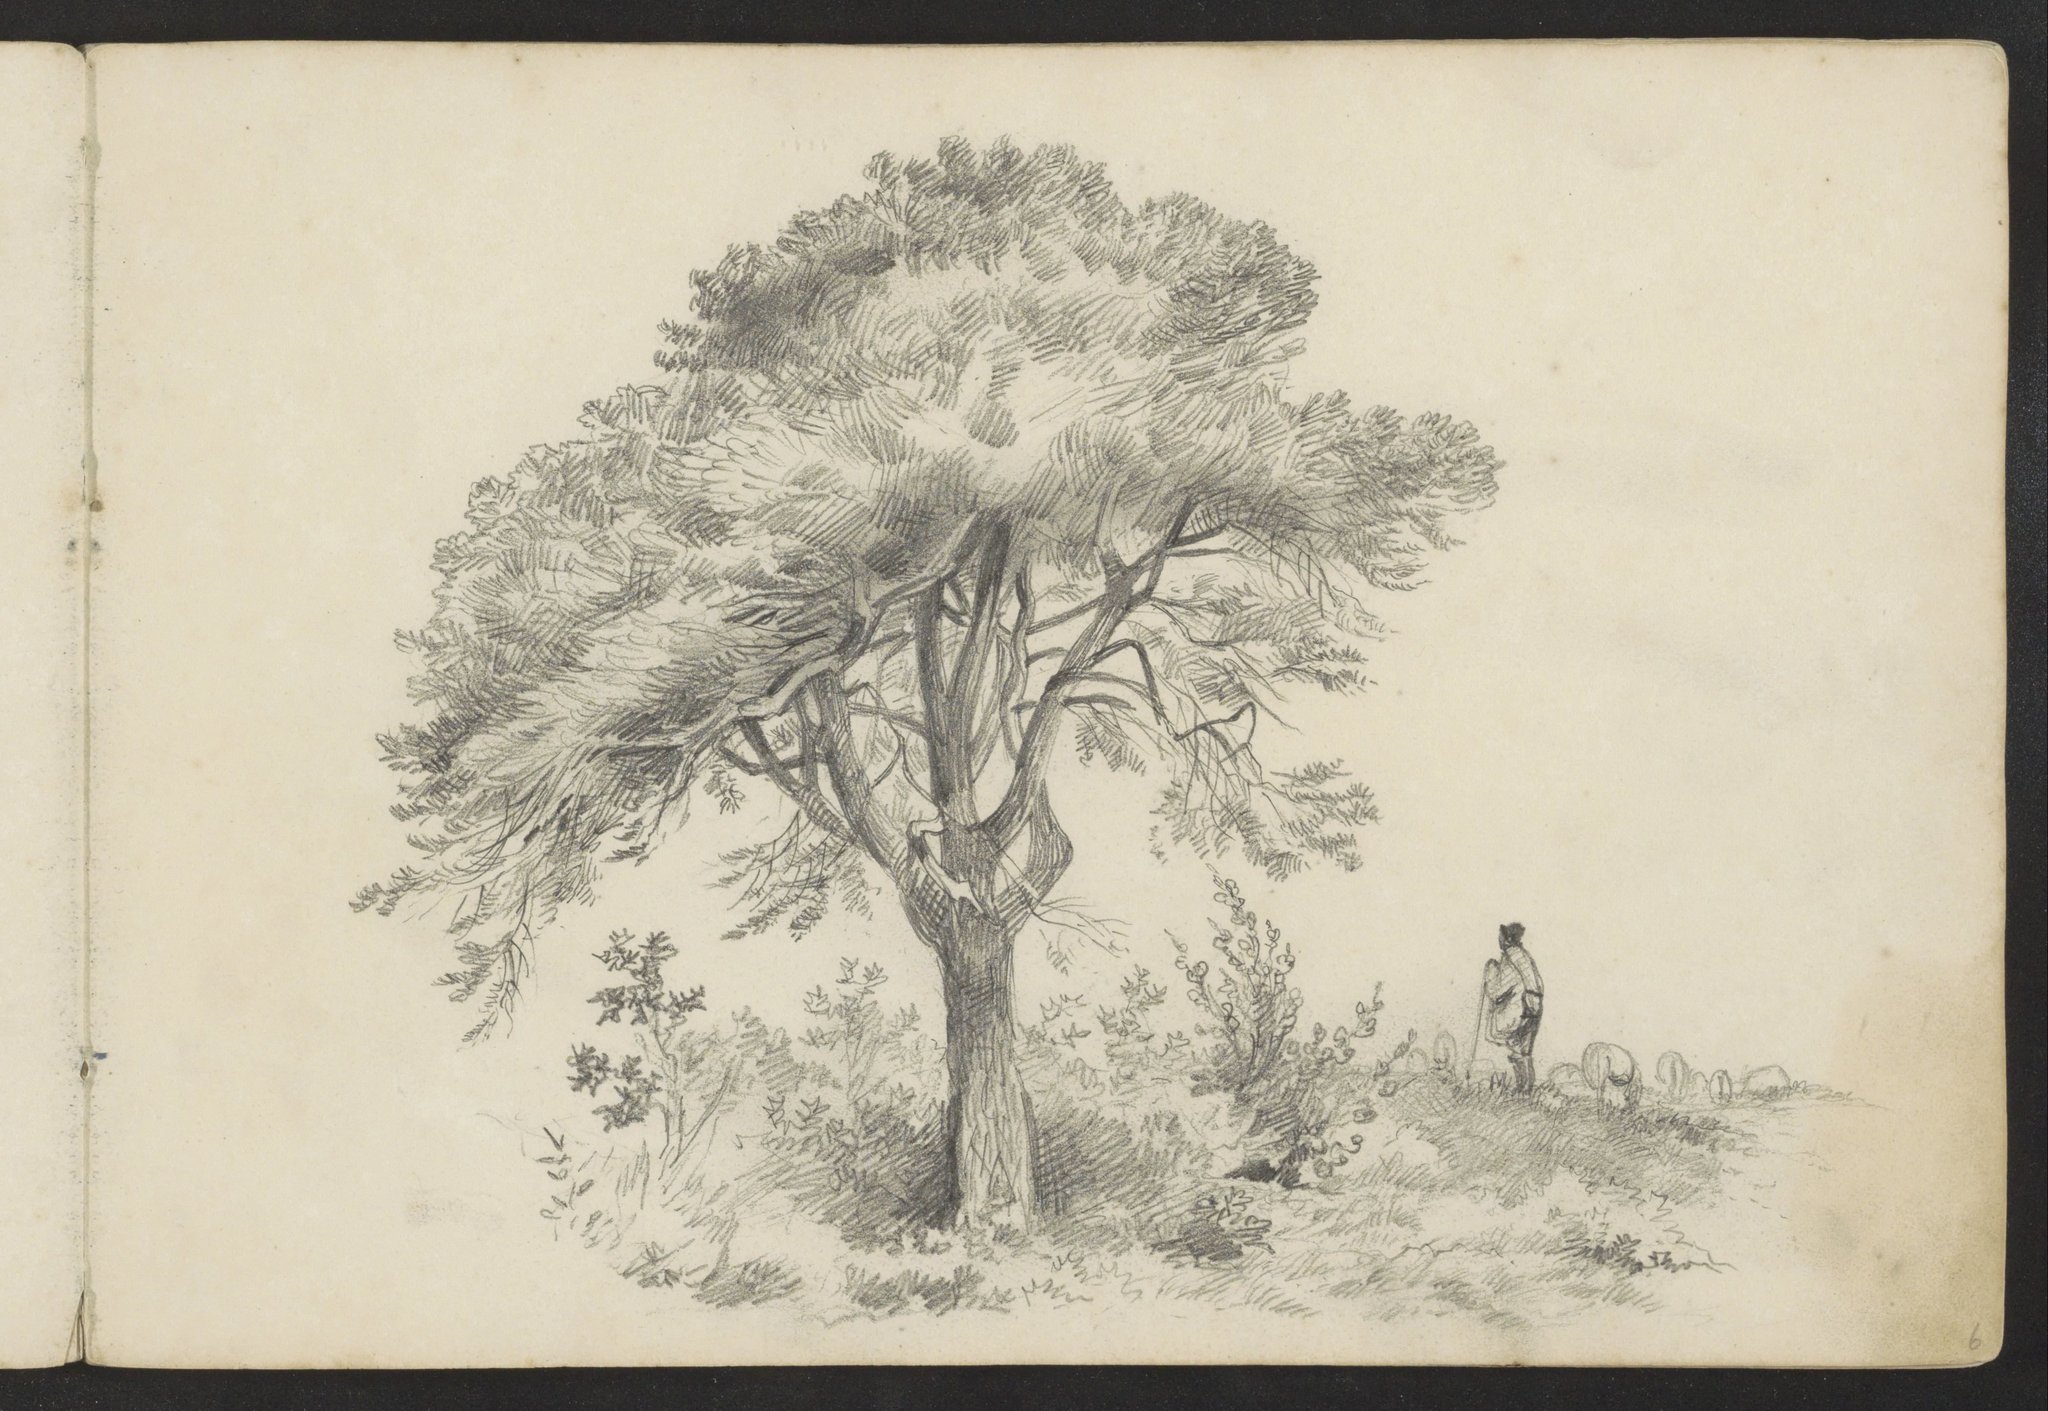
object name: sketchbook leaf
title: Schapenherder bij een boom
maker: johannes tavenraat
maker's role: draughtsman, painter, print maker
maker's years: 1809-1881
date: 1842-1868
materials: paper, pencil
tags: trees, herding, herdsman, herdswoman, shepherd, shepherdess, cowherd, etc., sheep, herd, flock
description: Blad 6 recto uit een schetsboek met 45 bladen.